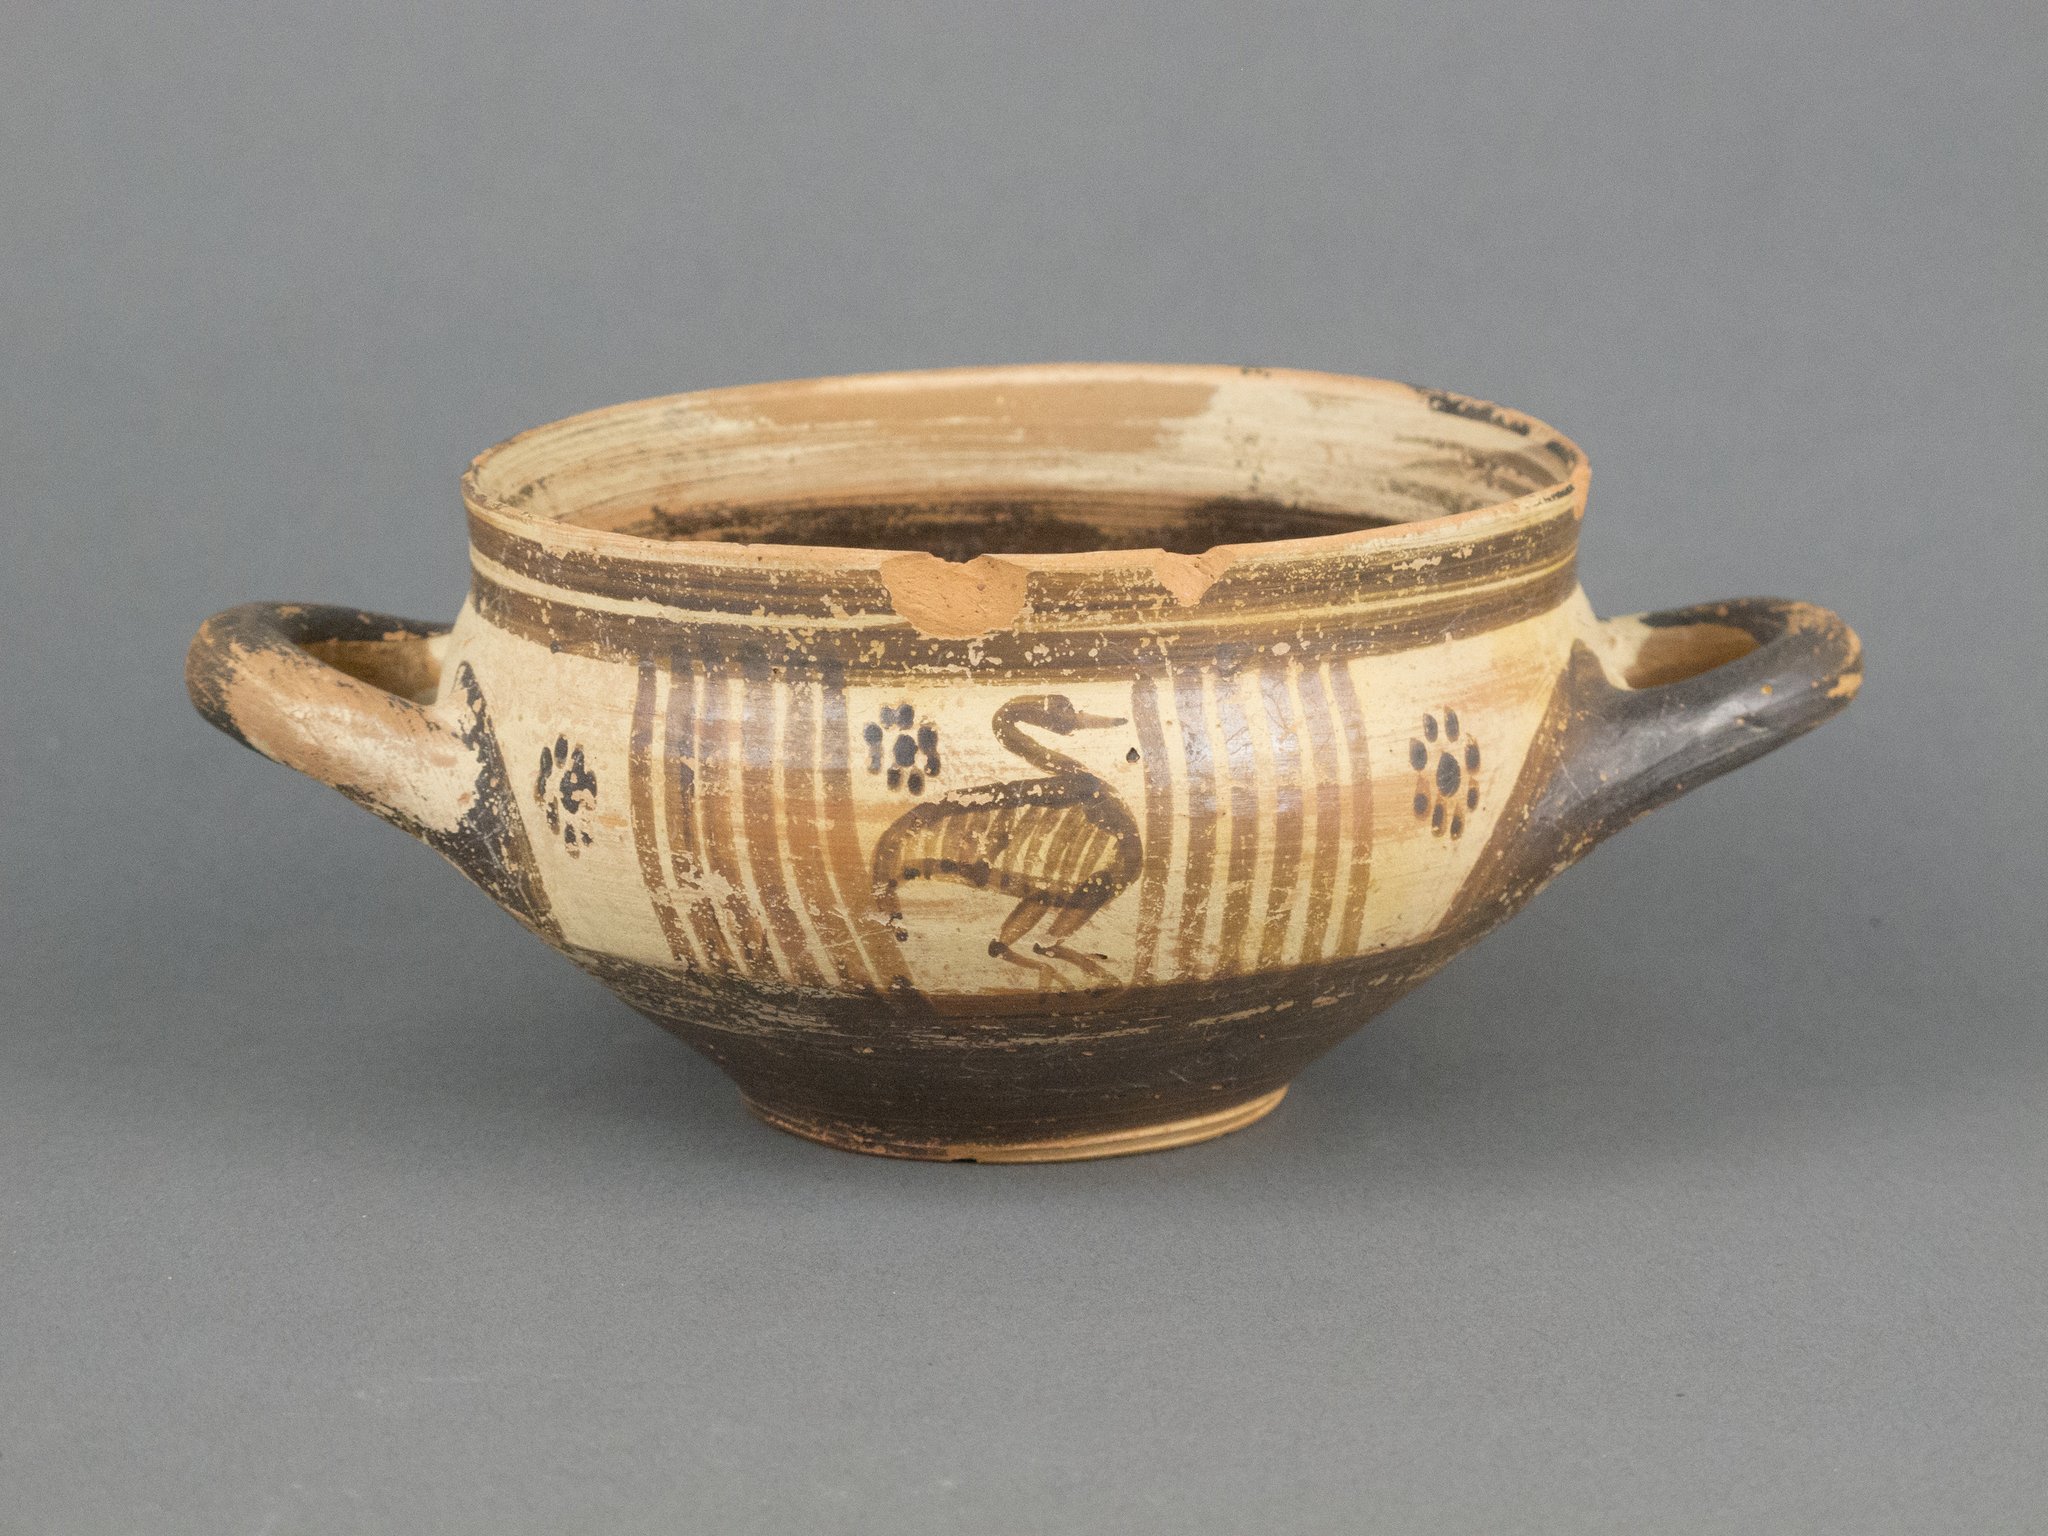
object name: skyphos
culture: cypriot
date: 800-701 BCE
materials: terracotta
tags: birds